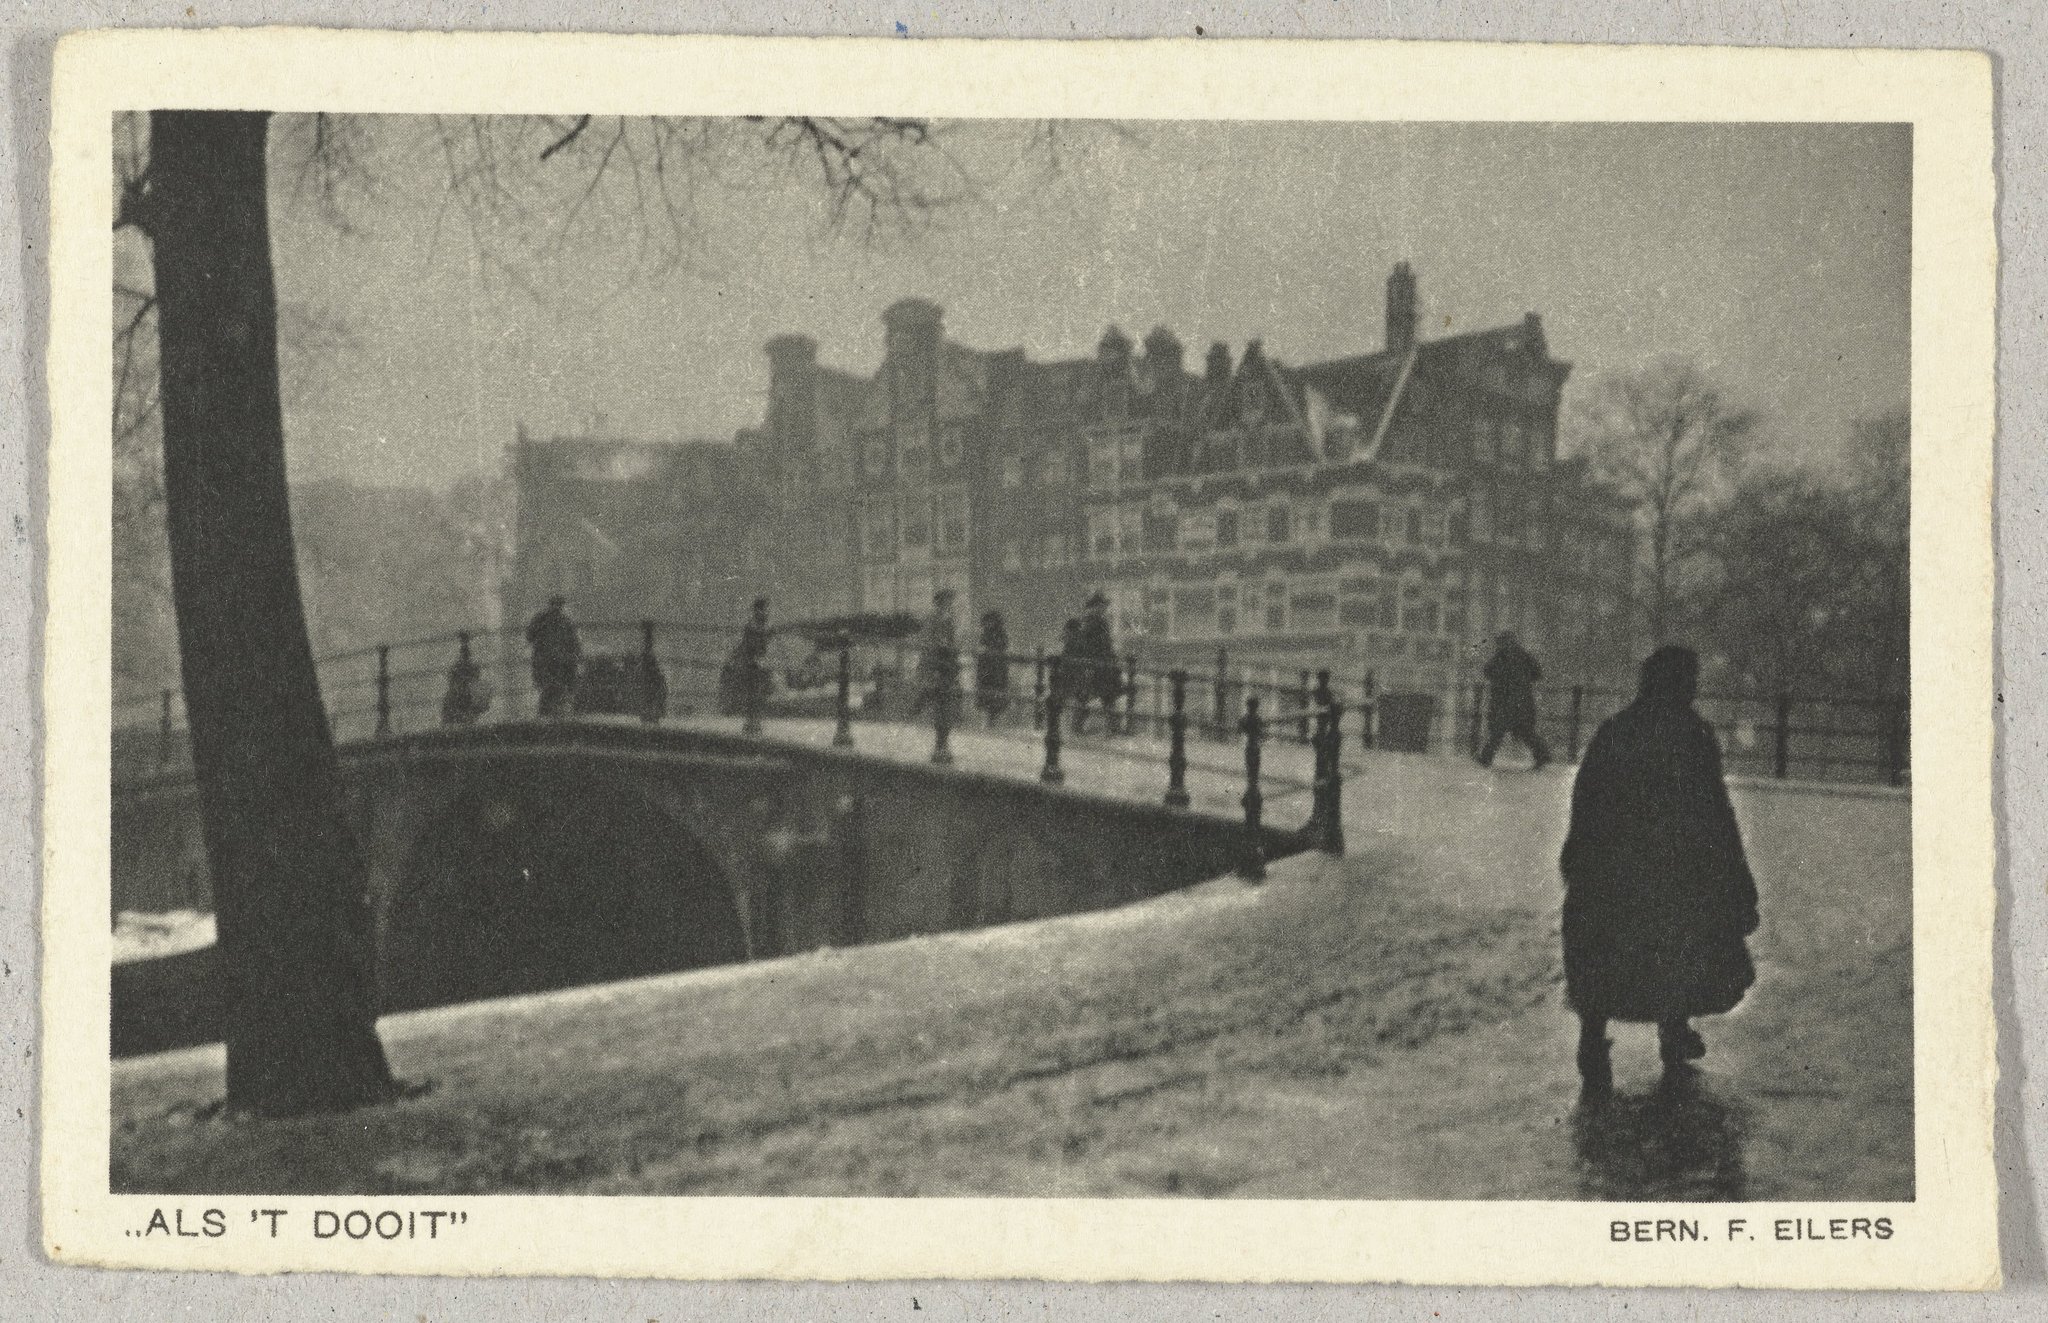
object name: ansichtkaart, prentbriefkaart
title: De Brouwesrgracht in wintertijd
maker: bernard eilers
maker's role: fotograaf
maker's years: 1878-1951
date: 1913-1940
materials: paper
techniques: rotogravure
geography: amsterdam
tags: canals, waters (in city), snow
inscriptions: annotation: ‘serie: A, Amsterdam - Brouwersgracht, hoek Korte Prinsengracht Amsterdam gerasterd’, name: ‘Bern. F. Eilers’, annotation: ‘Eilers Artistieke kaarten - uitg.-mij. "Kosmos" - Amsterdam’